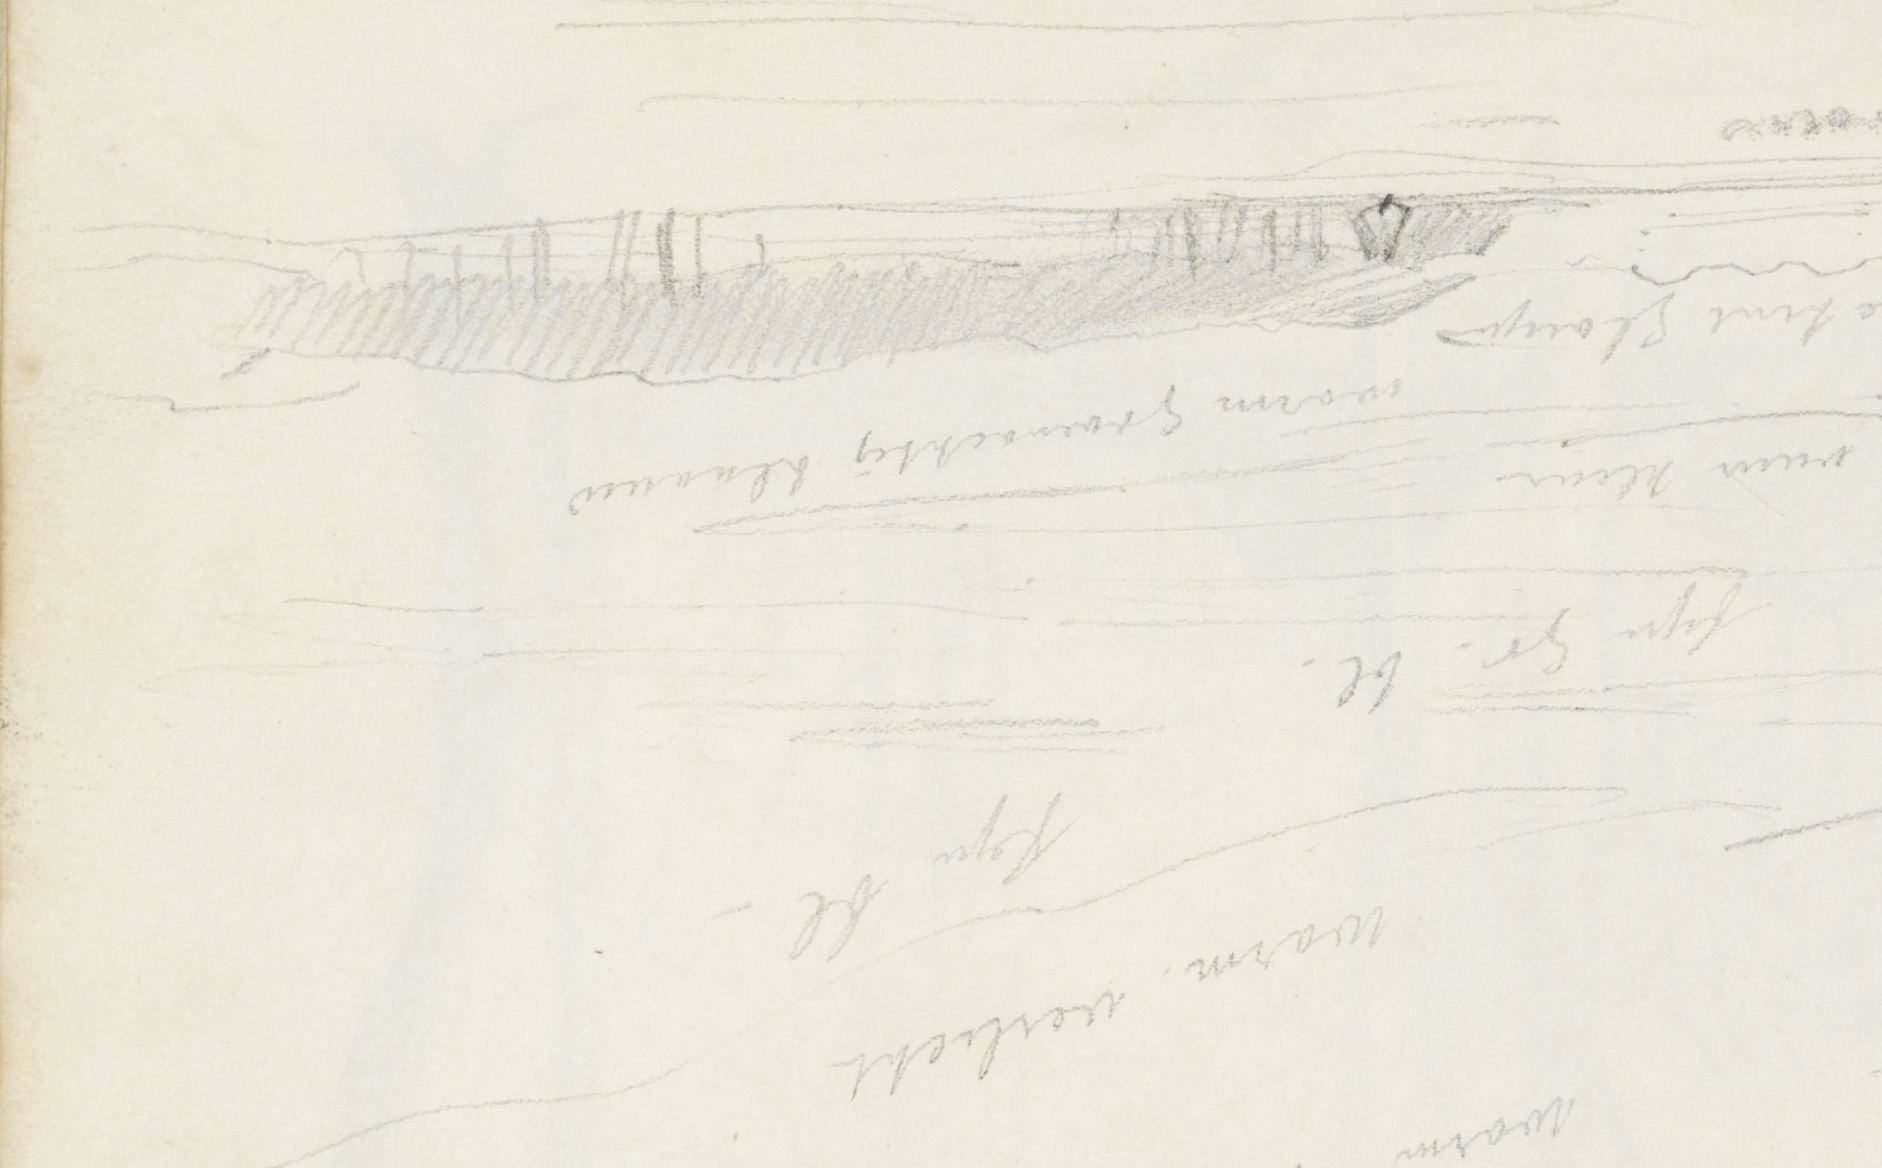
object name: sketchbook leaf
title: Weide met bomen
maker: johannes tavenraat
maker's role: draughtsman, painter, print maker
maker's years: 1809-1881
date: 1840-1841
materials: paper, pencil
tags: trees, meadow, pasture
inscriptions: kleurnotitie, handgeschreven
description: Blad 38 verso uit een schetsboek met 41 bladen.